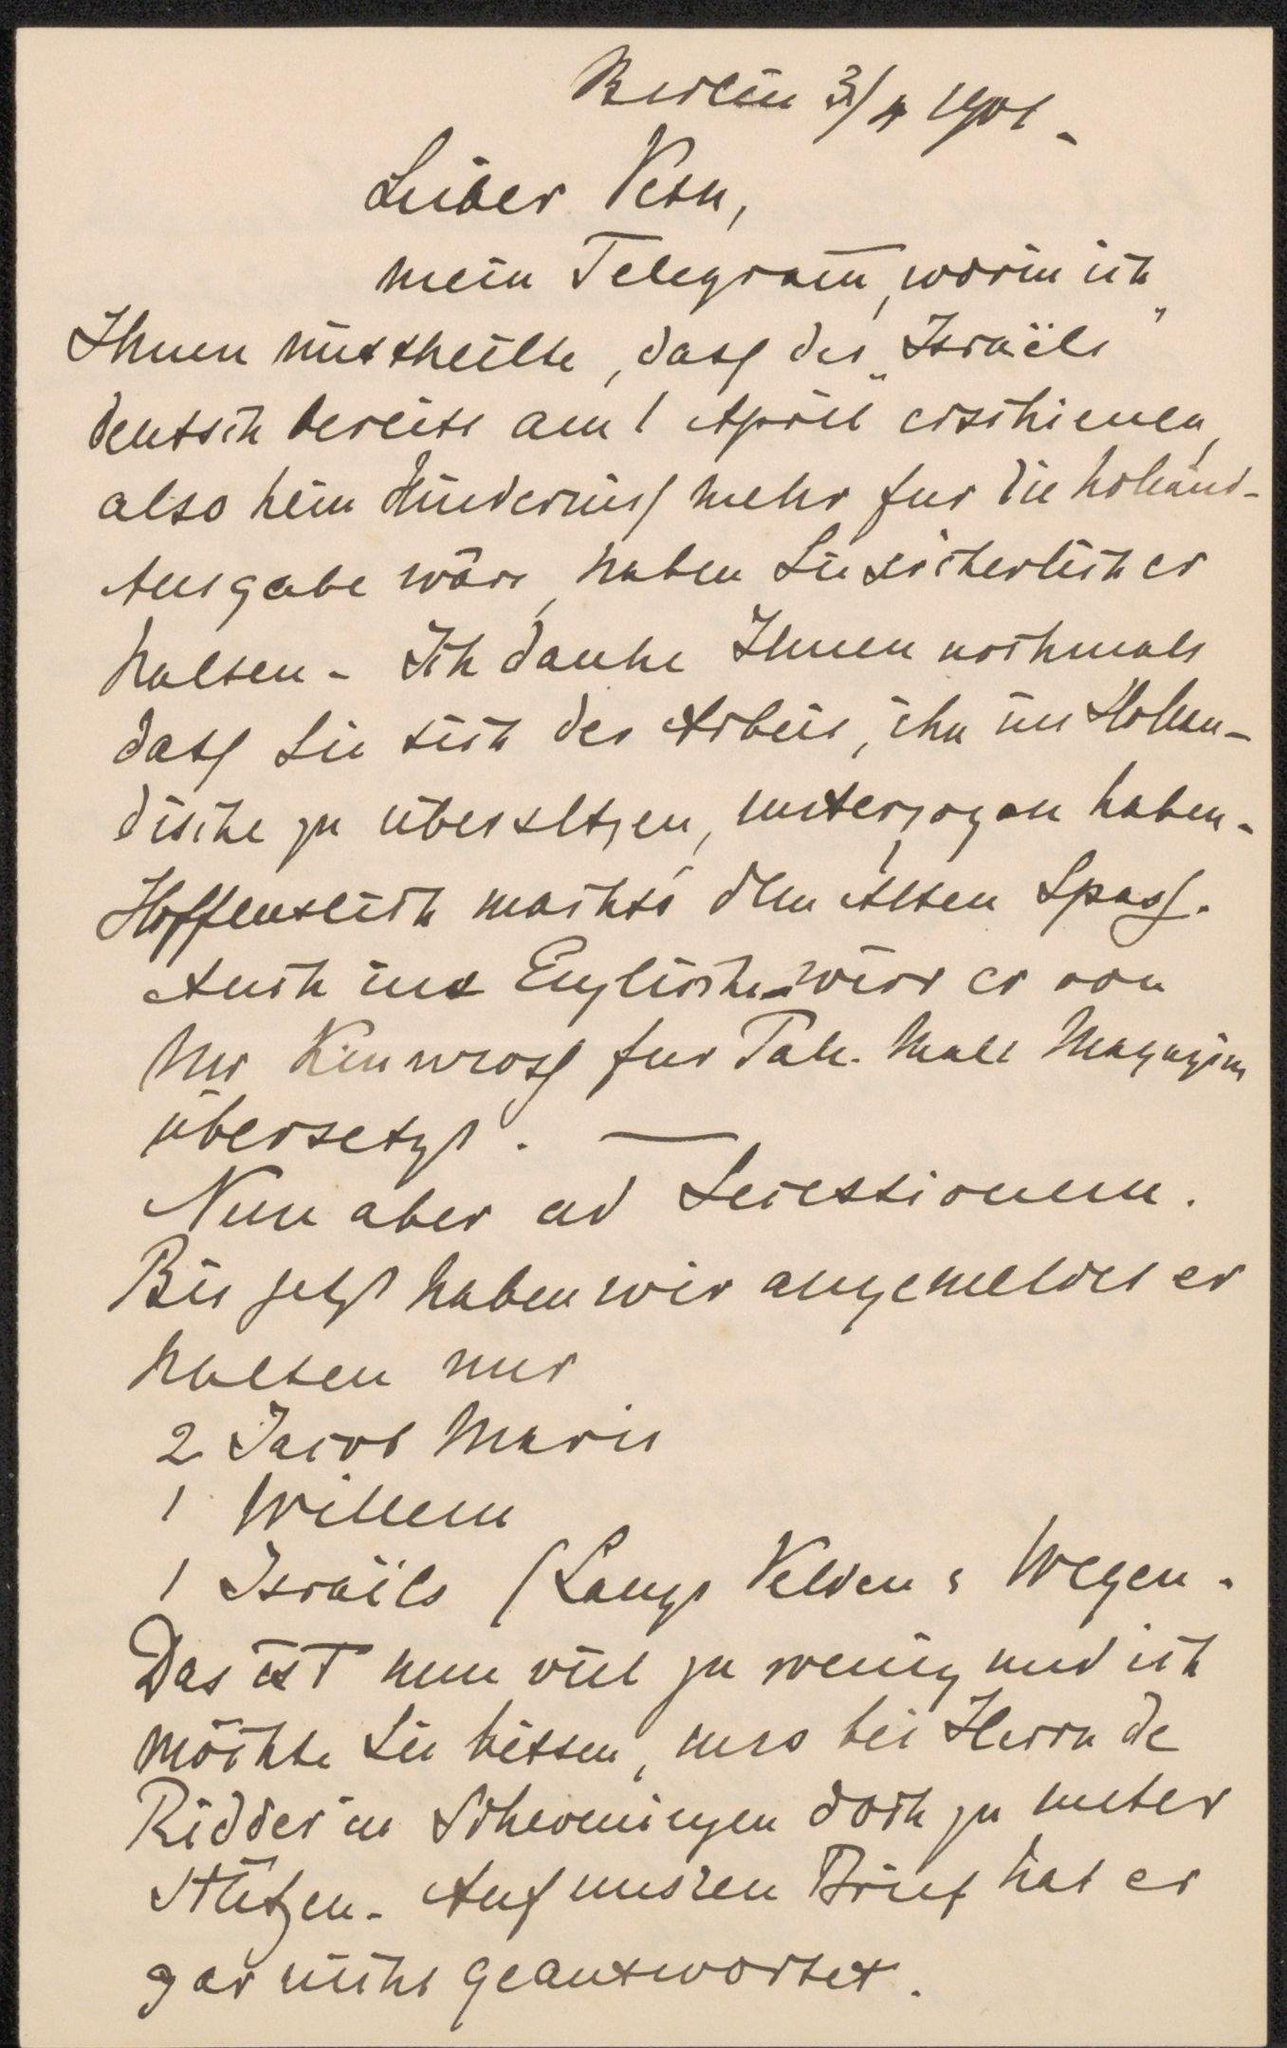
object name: letter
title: Brief aan Jan Veth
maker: max liebermann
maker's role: draughtsman, print maker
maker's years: 1847-1935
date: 1901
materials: ink, paper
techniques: pen, writing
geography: berlin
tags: jozef israëls, rotterdam, george hendrik breitner, dordrecht, amsterdam, print maker, designer, jan veth, brussels, henri hymans, the hague, painter, draughtsman, willem maris, jacob maris, isaac israels, politician, elbert jan van wisselingh, antwerp, paris, nijmegen, exhibition ~ art, historical persons (portraits and scenes from the life), printed matter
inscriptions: collector's mark: ‘RPK’, watermark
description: Opgenomen in: Ernst Braun, Max Liebermann: Briefe 1896-1901, Baden-Baden: Deutscher Wissenschafts-Verlag, 2012, Band 2, p. 392-394.